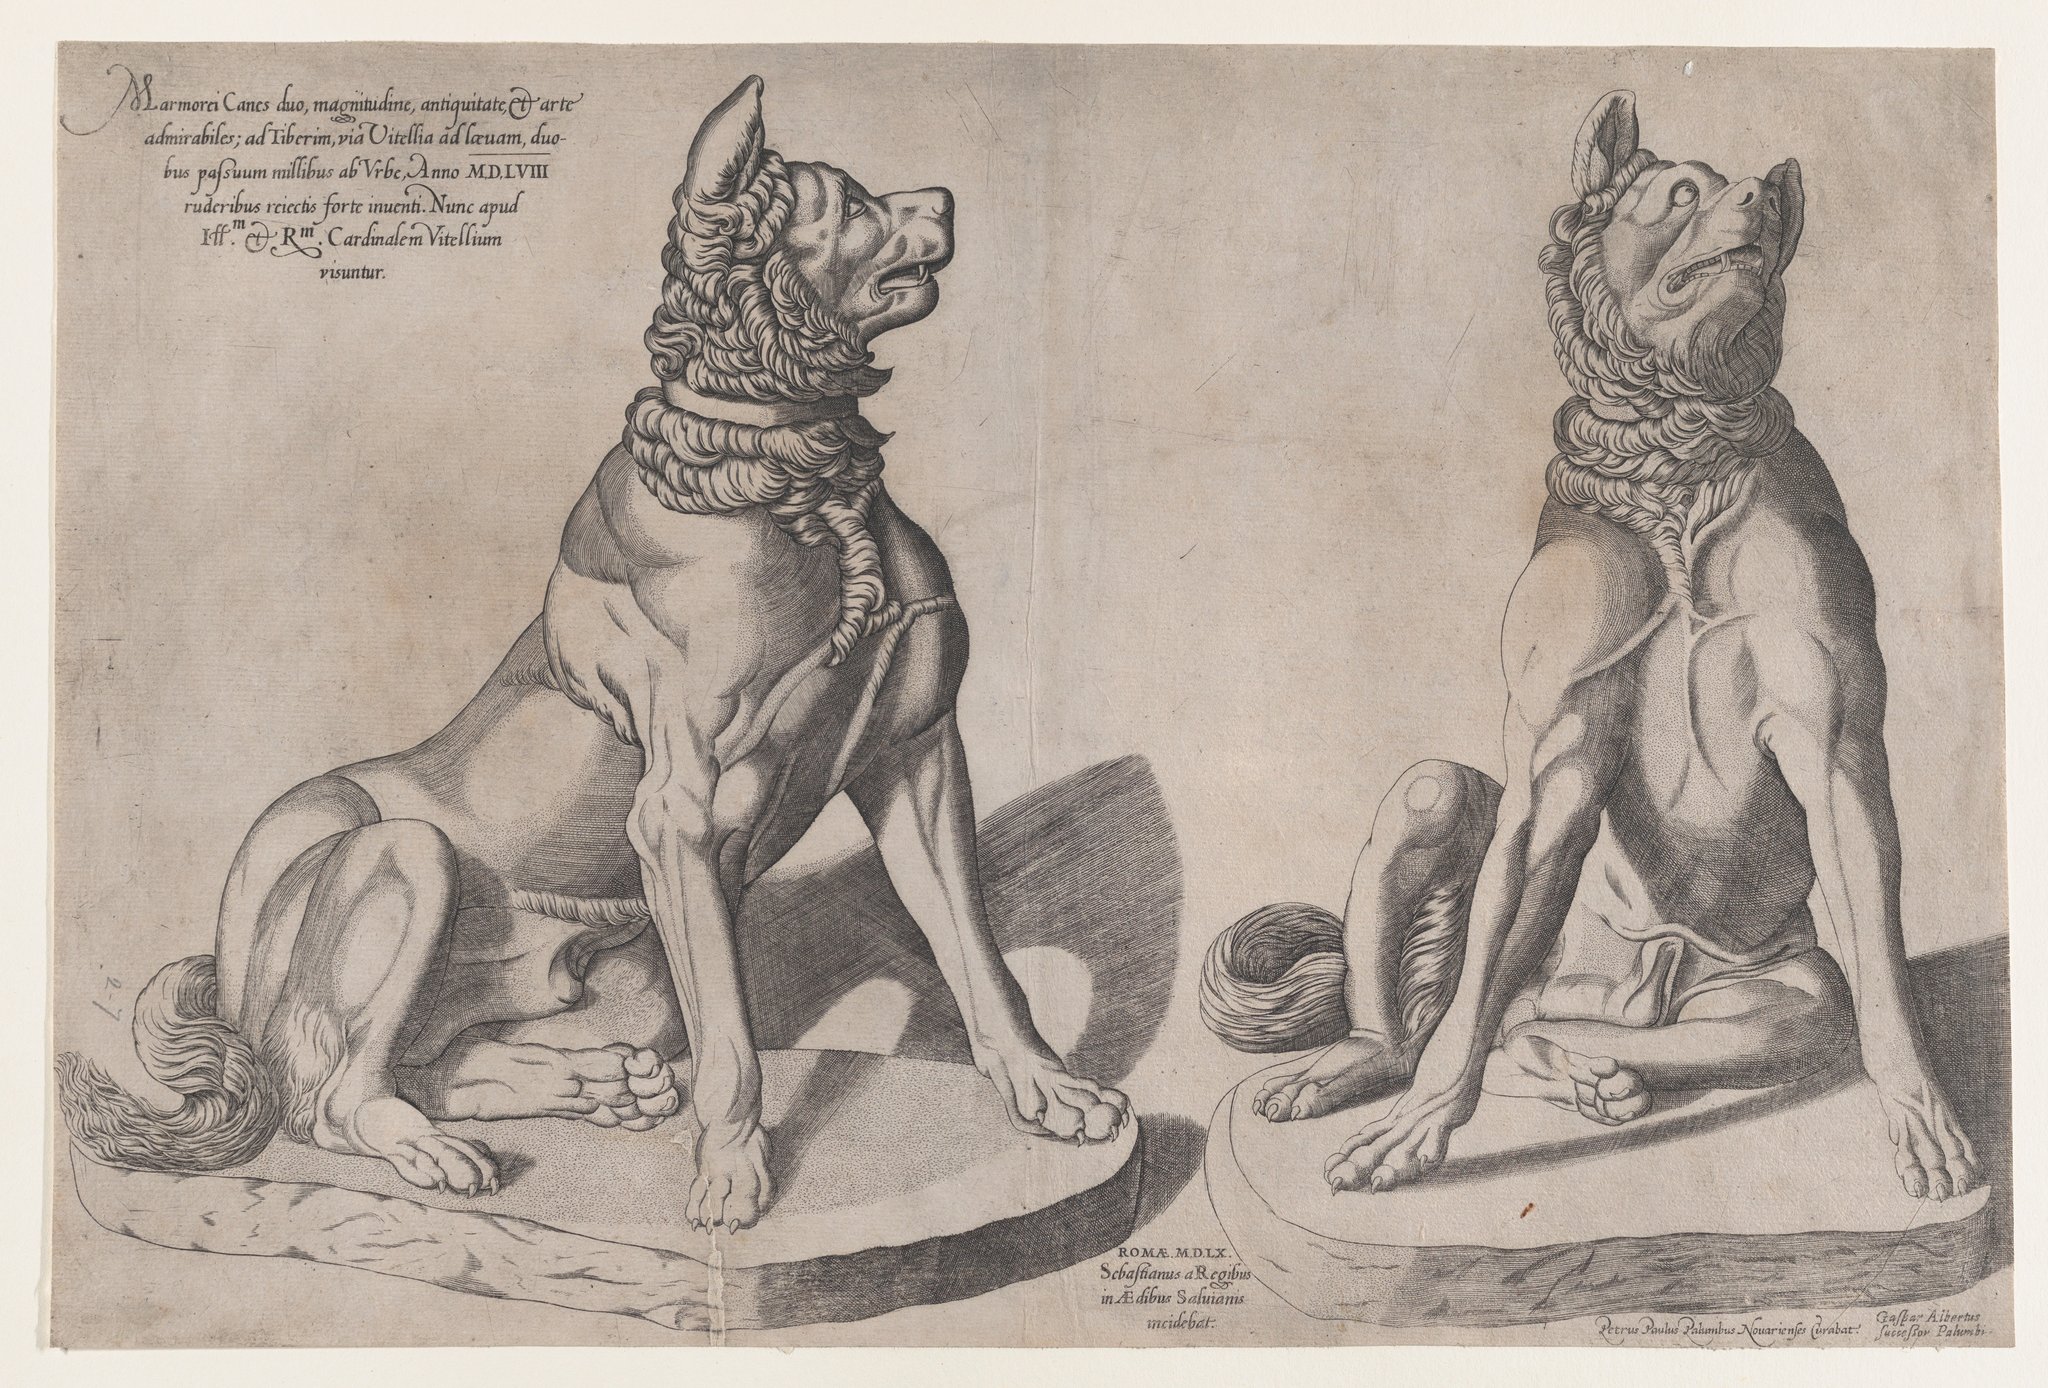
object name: print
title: Two Dogs, from "Speculum Romanae Magnificentiae"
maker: sebastiano di re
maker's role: artist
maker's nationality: italian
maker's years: 1557-1563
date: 1558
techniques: engraving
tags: dogs